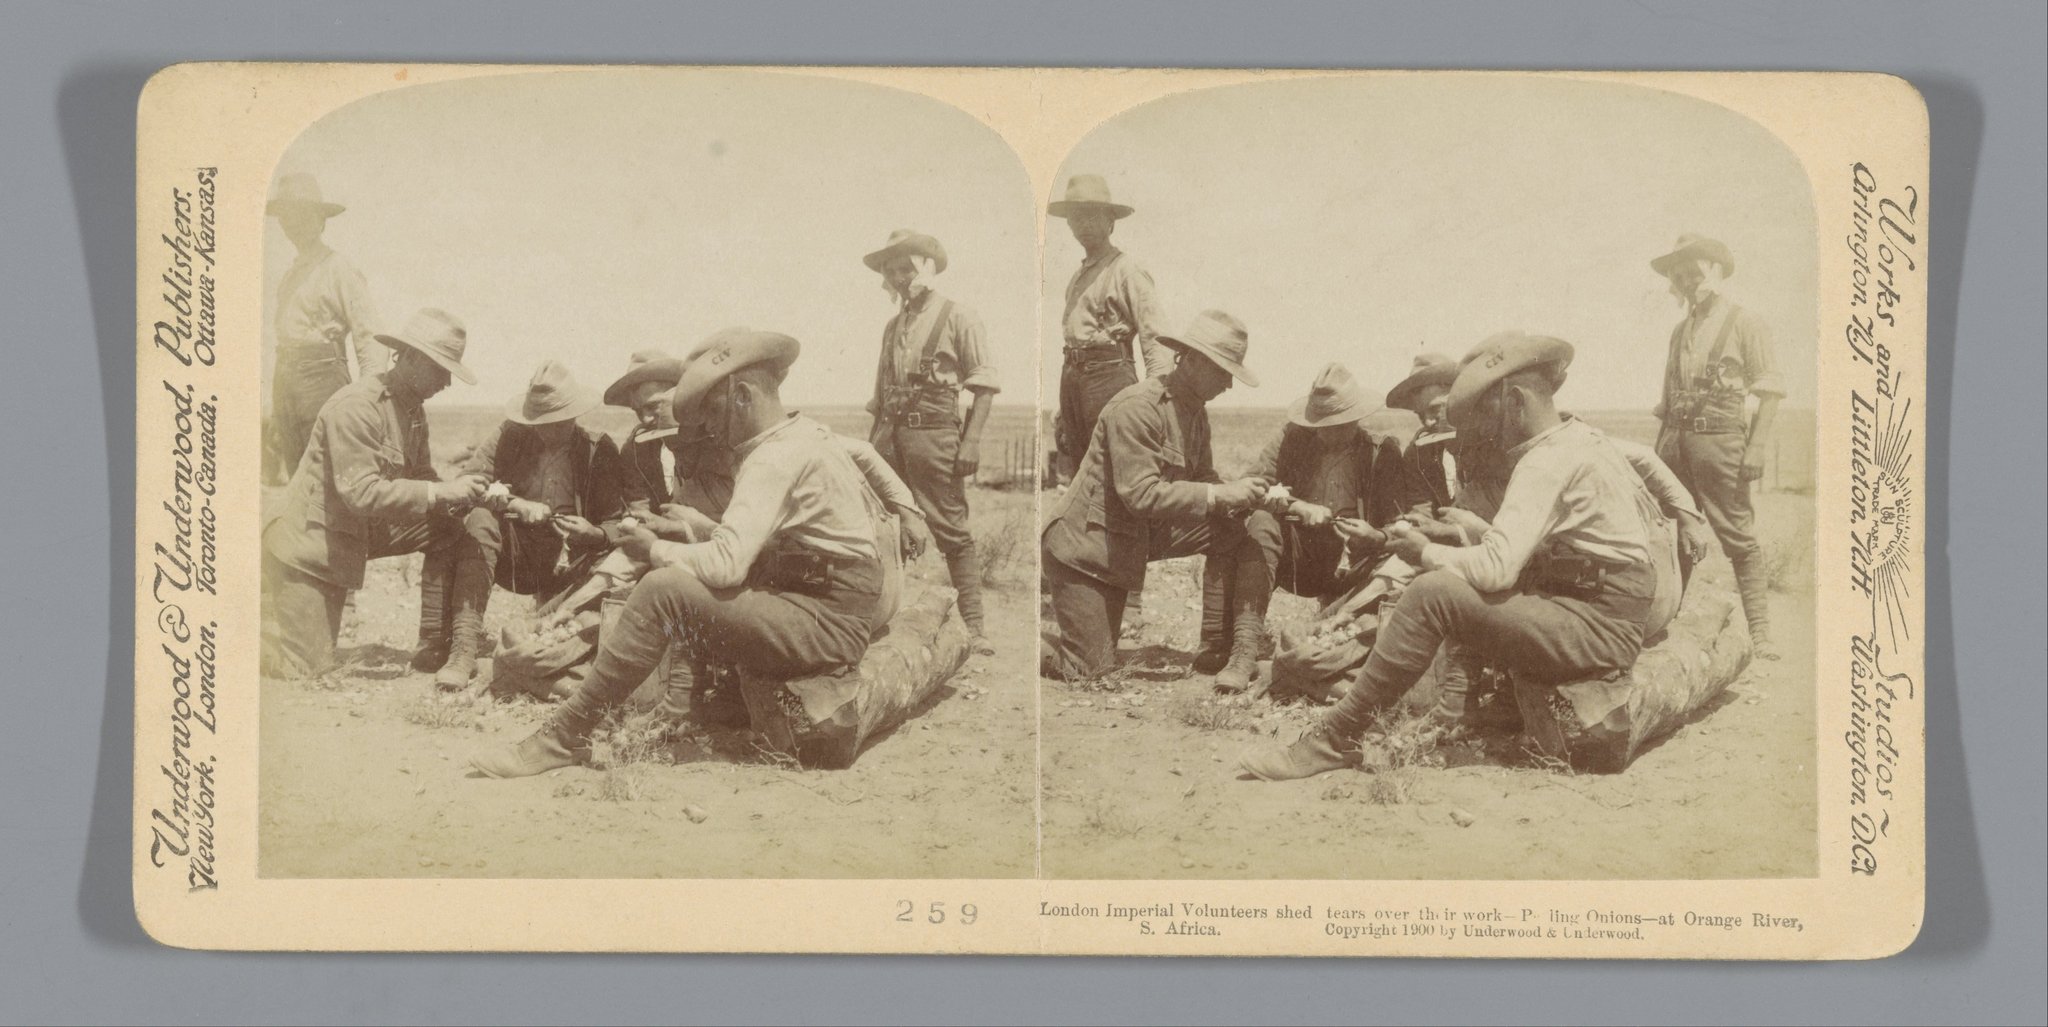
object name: stereograph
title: Vrijwilligers schillen uien, nabij Oranjerivier, Zuid-Afrika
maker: Anonymous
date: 1900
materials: cardboard, paper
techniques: albumen print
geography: new york city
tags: preperation of food ~ military service, the soldier; the soldier's life, (non-fruit) products of plants or trees: onion, cleaning vegetables - cc - in the open air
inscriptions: inscription: ‘Works and Studios ~/ Arlington, N.J. Littleton, N.H. Washington, D.C.’, inscription, number: ‘259’, copyright notice: ‘Copyright 1900 by Underwood & Underwood.’